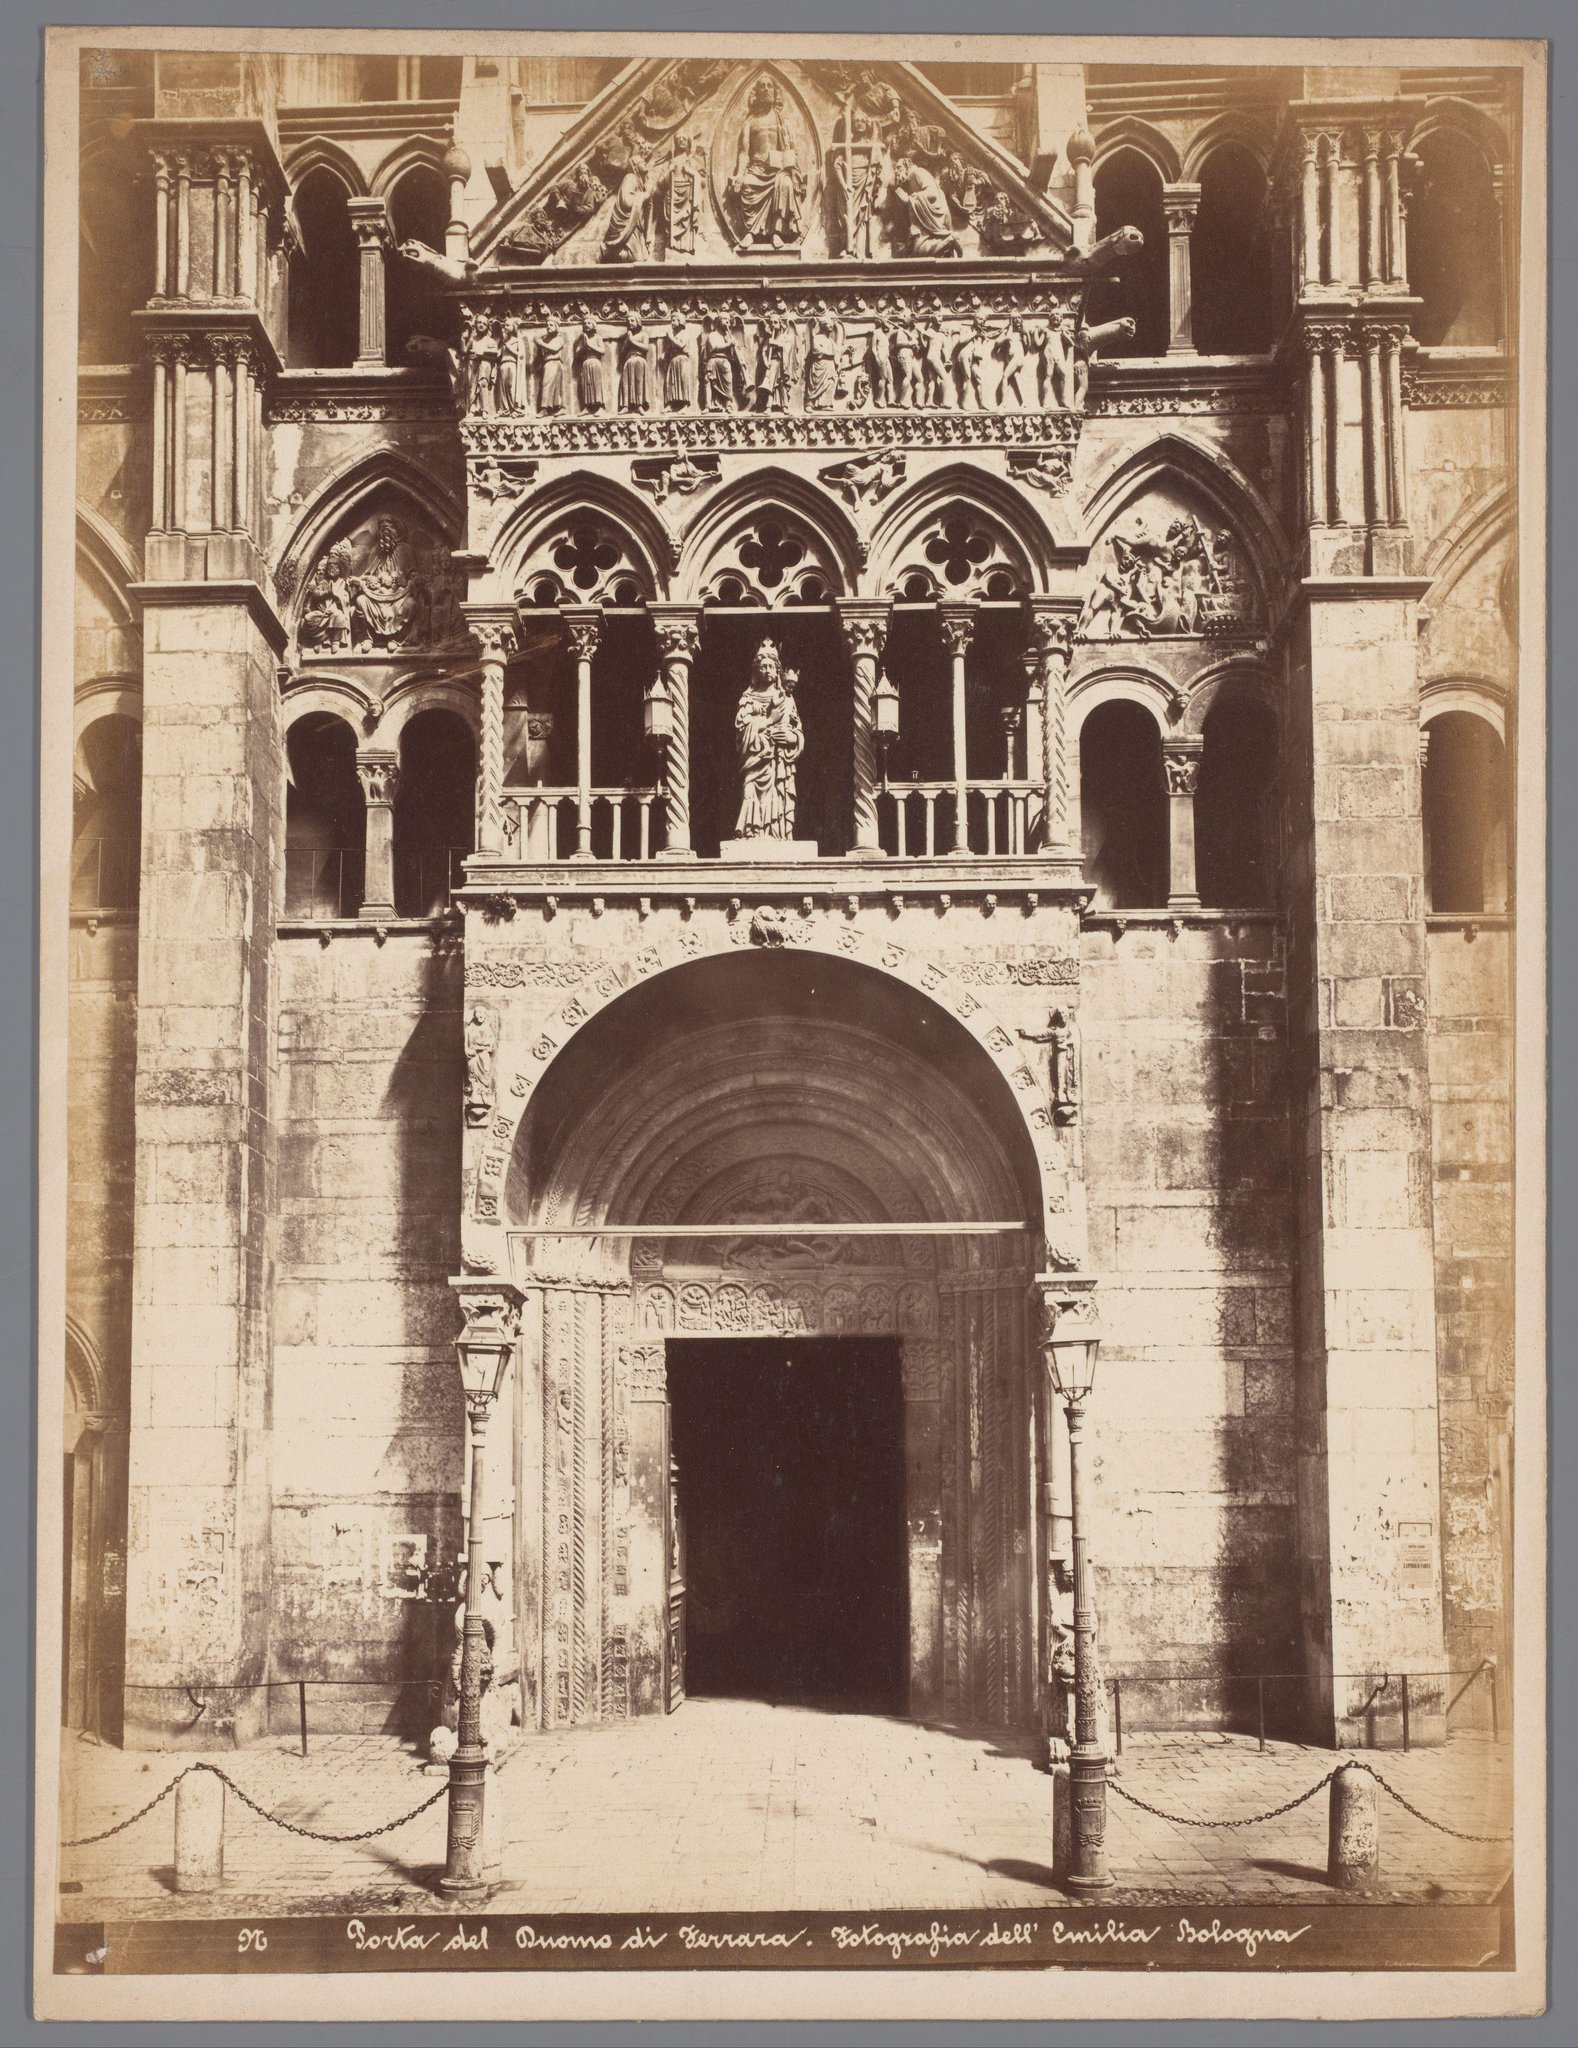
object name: photograph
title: Porta del Duomo di Ferrara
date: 1865-1900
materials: cardboard, paper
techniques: albumen print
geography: ferrara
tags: church (exterior)